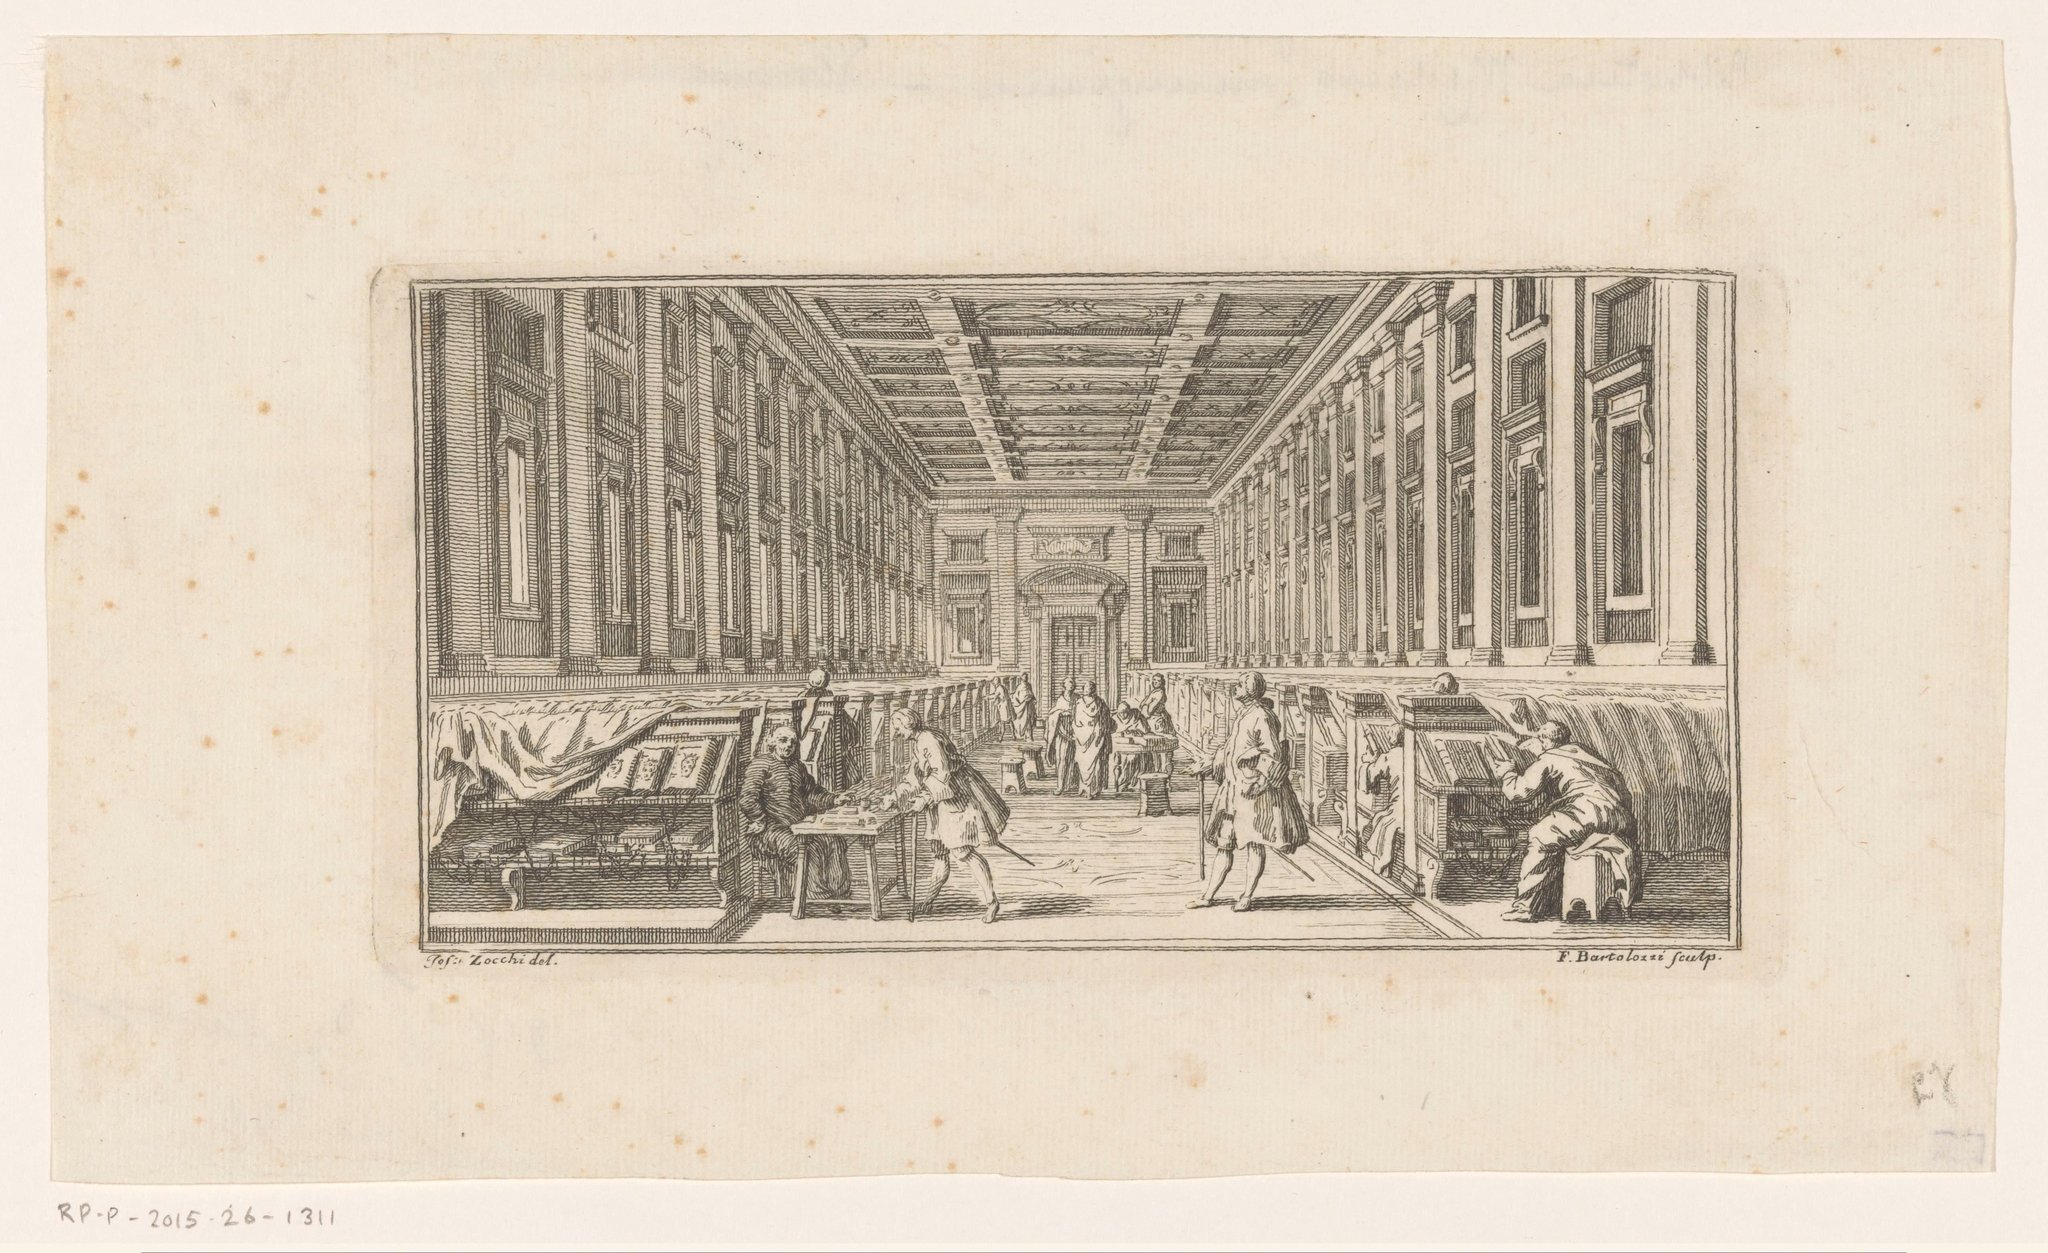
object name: print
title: Biblioteca Laurenziana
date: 1750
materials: paper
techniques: etching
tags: study; 'studiolo'; library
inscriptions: watermark, collector's mark: Lugt 4780, collector's mark: Lugt 2228, collector's mark: Lugt 4779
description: Interieur van de Biblioteca Laurenziana in het klooster van San Lorenzo in Florence. Verschillende monniken en geleerden bestuderen manuscripten in de leeszaal. De boeken worden tegen het stof beschermd door overhangende doeken.